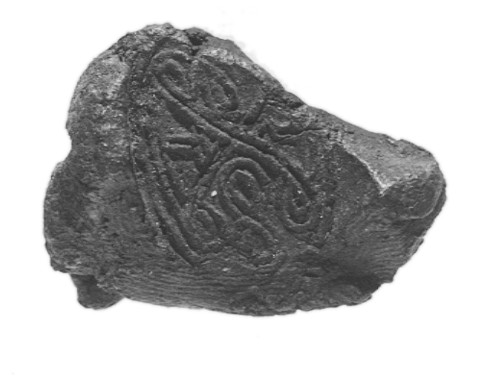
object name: sealing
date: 2030-1640 BCE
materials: clay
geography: egypt